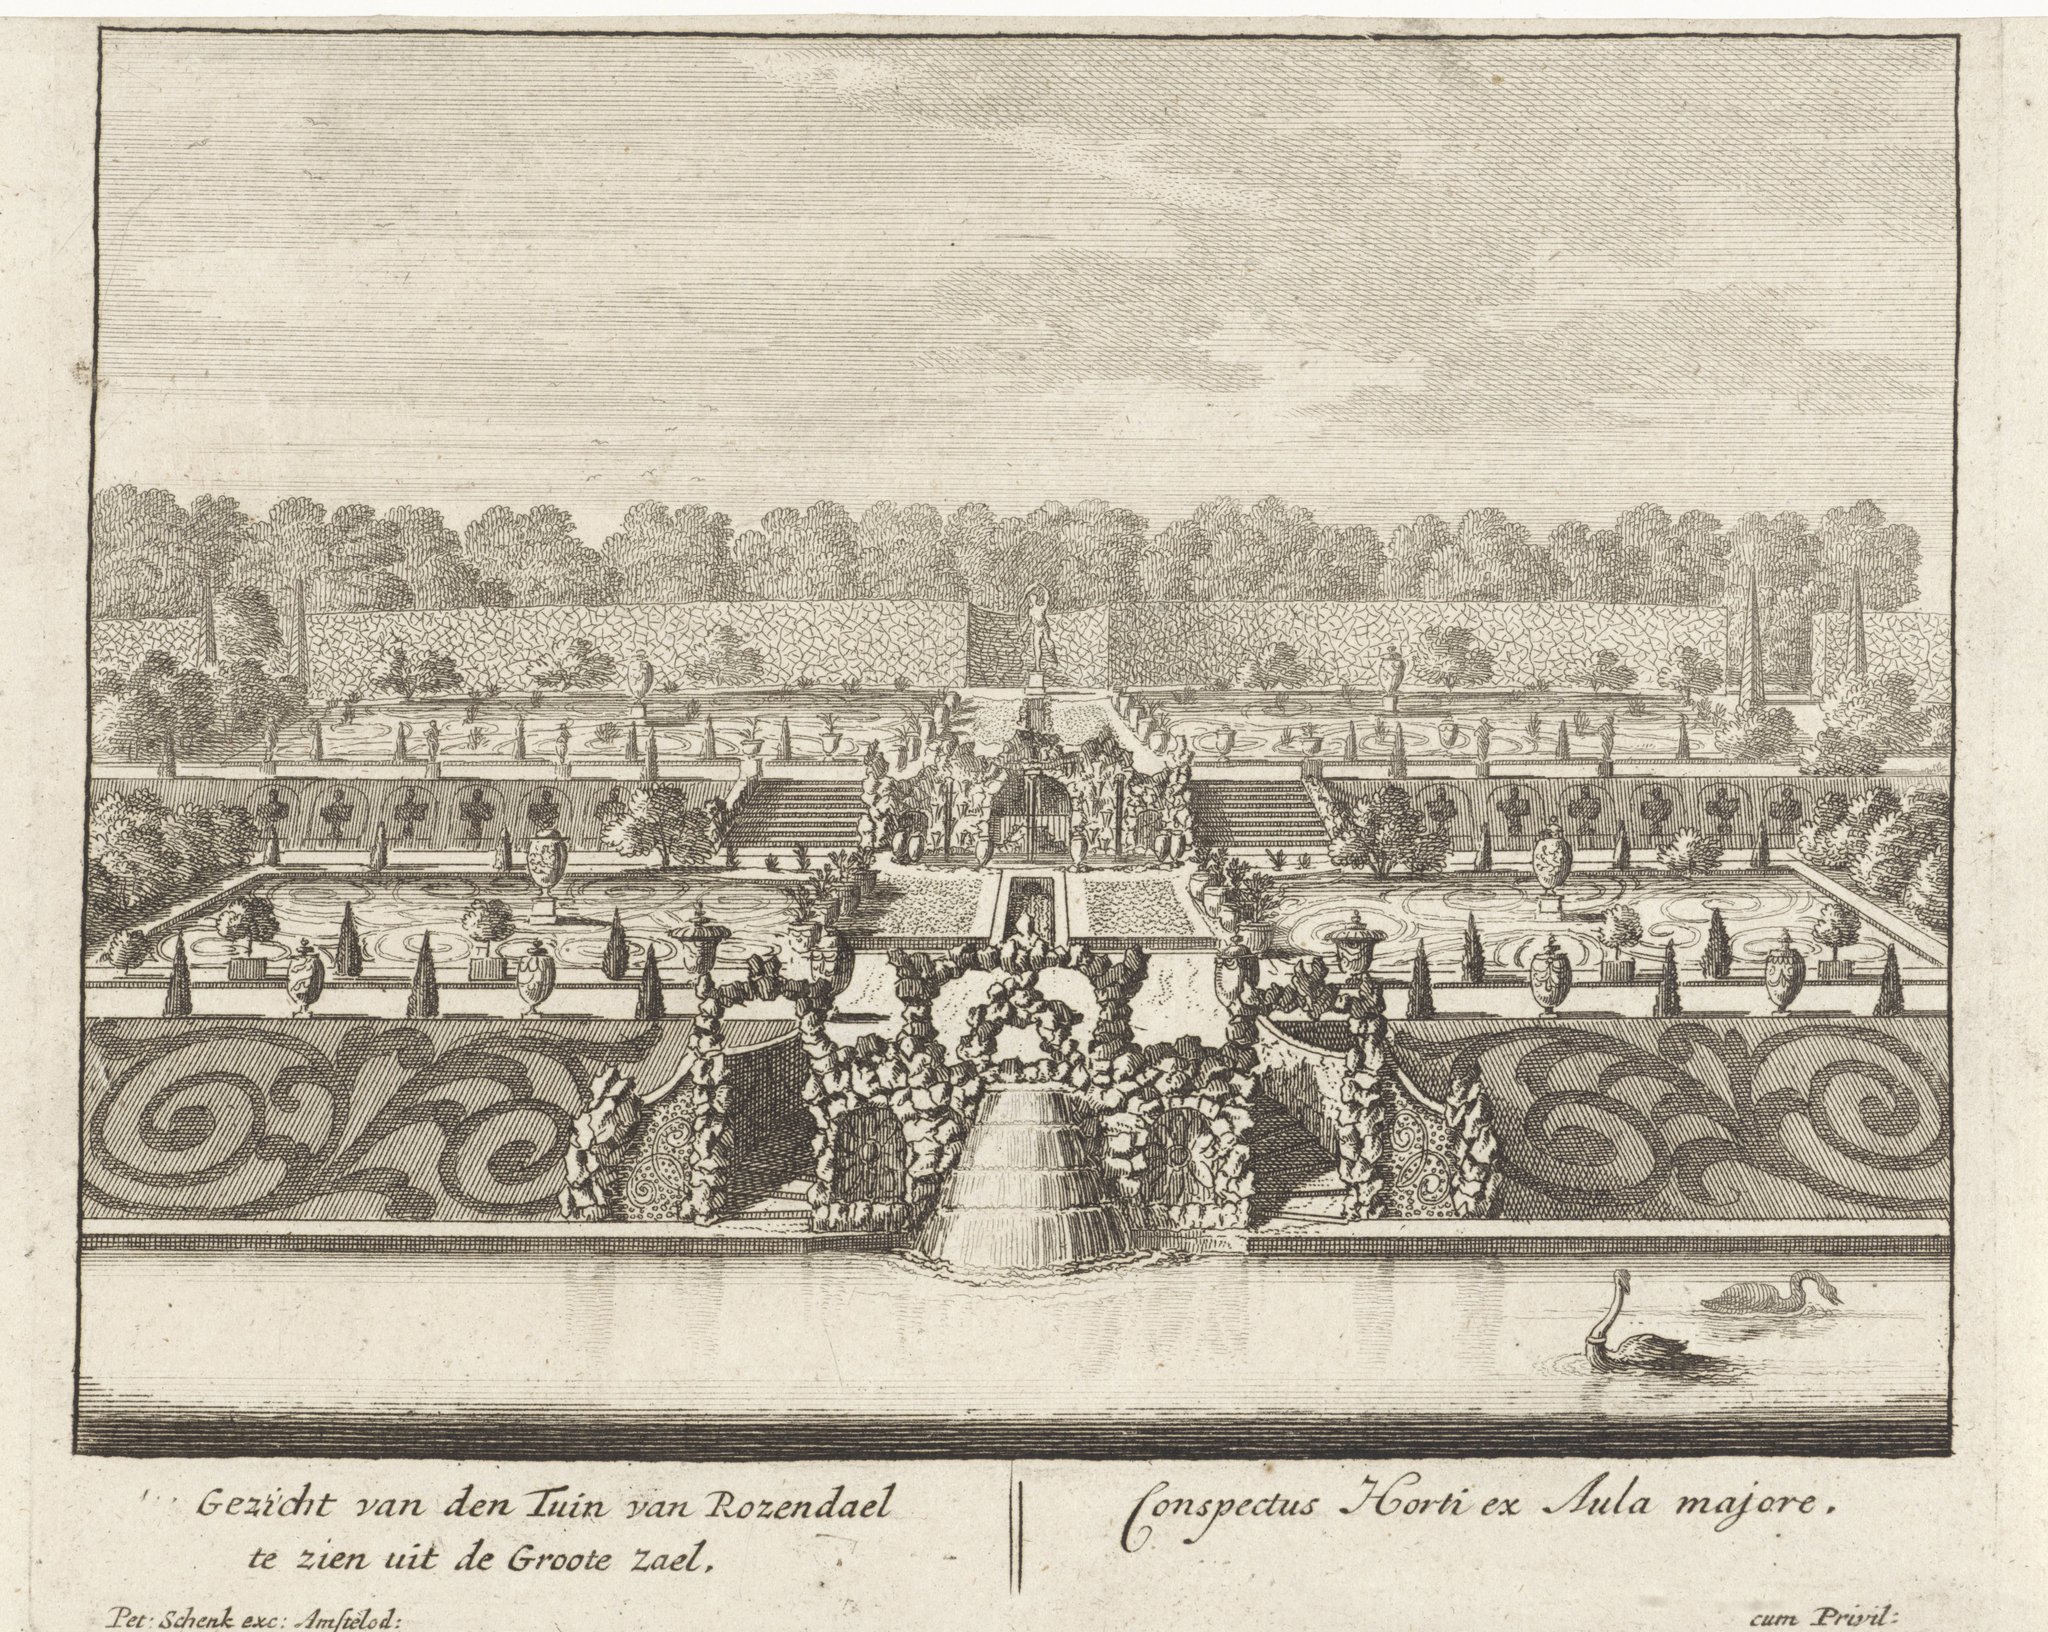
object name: print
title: Tuin van Kasteel Rosendael, gezien vanuit de grote zaal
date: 1675-1711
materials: paper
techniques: etching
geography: amsterdam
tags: water-birds: swan, french or architectonic garden; formal garden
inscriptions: collector's mark: Lugt 2228